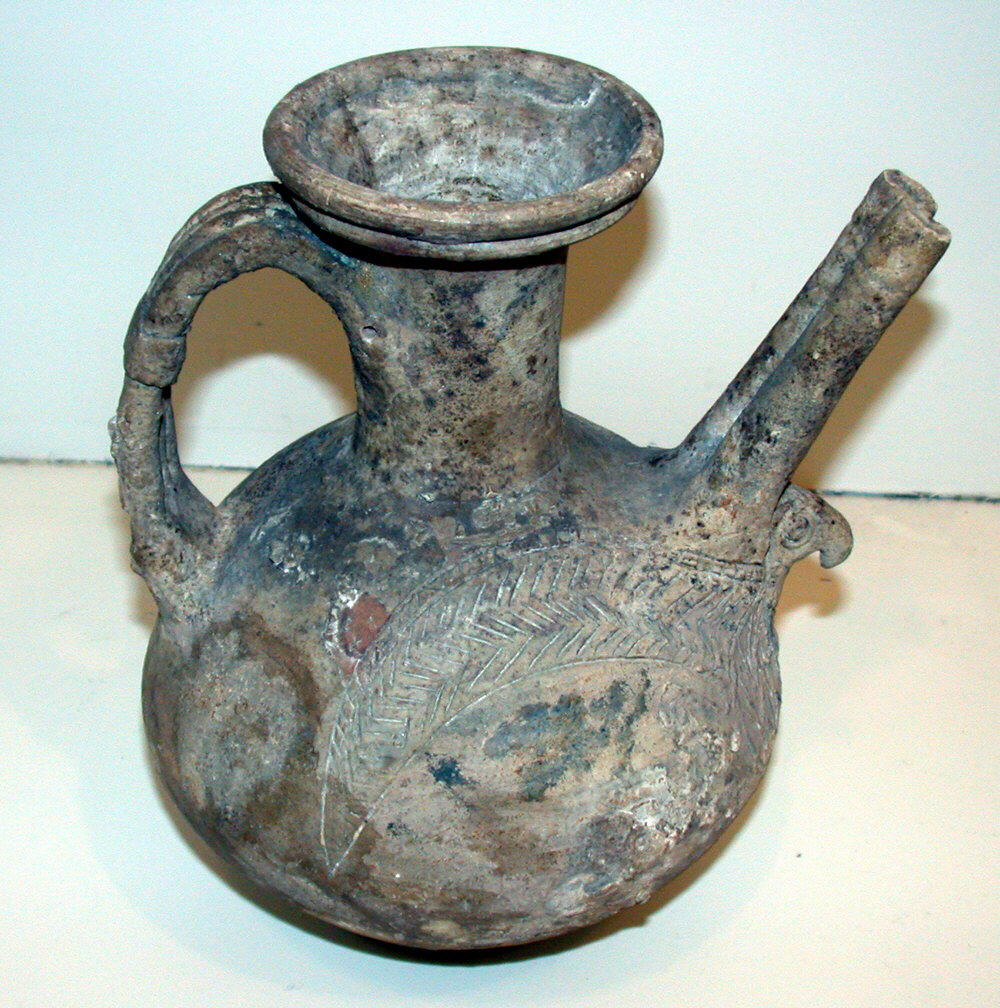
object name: jar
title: Spouted jar with eagle incised in high relief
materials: ceramic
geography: syria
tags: eagles